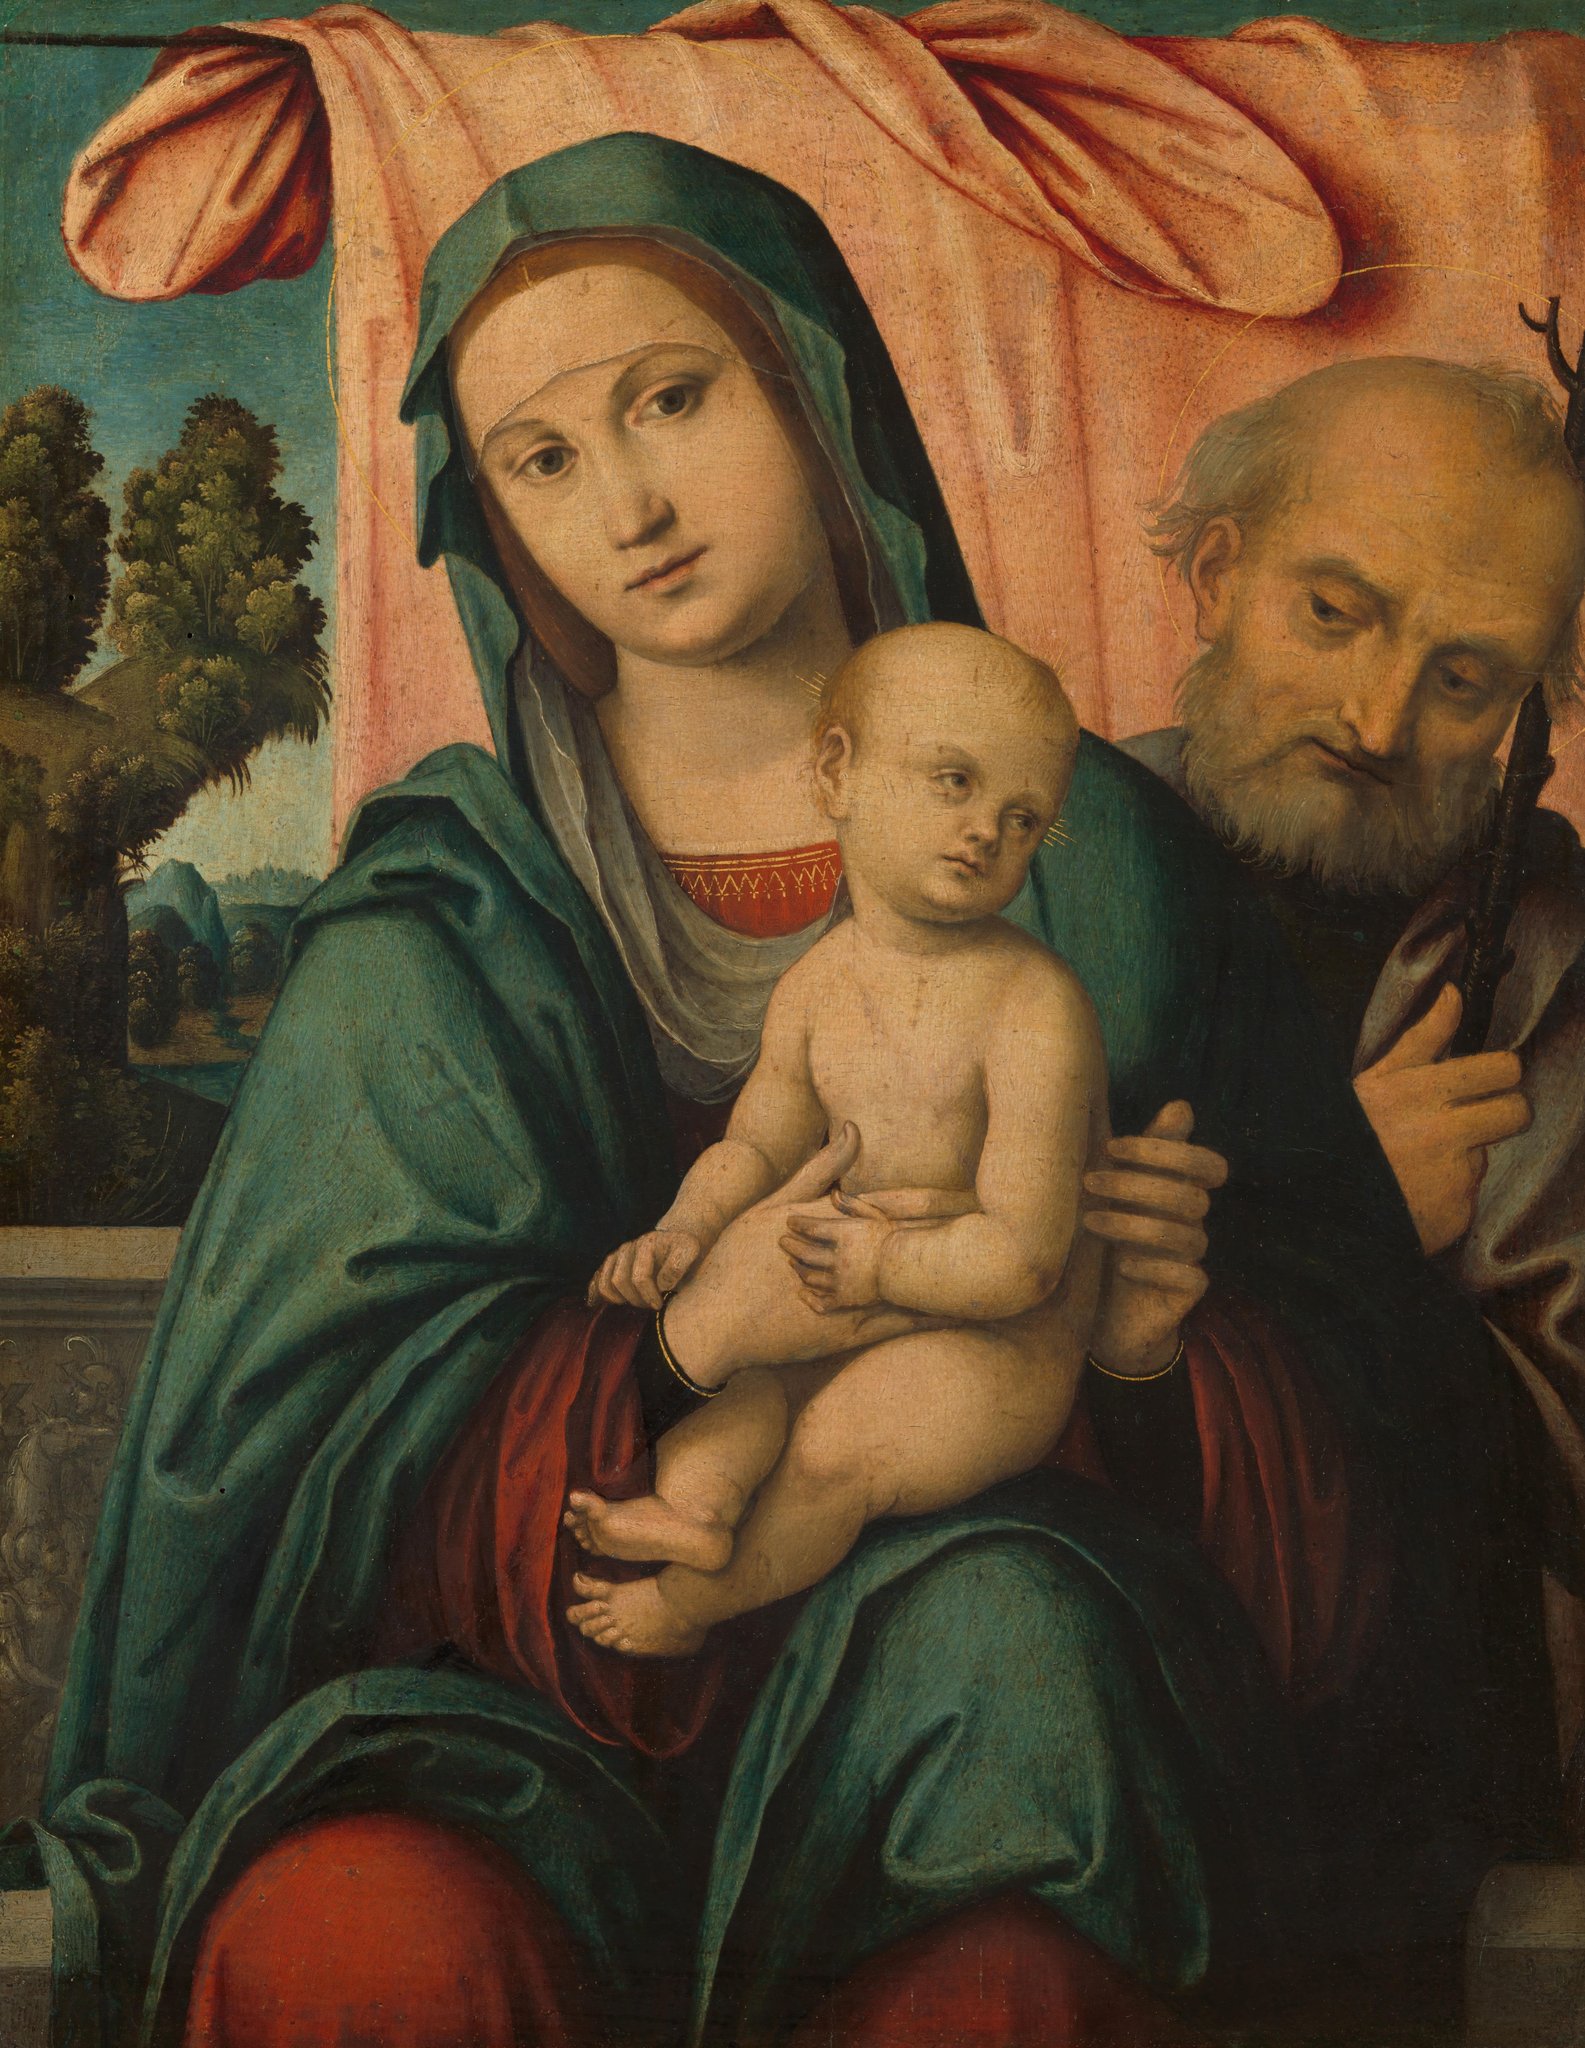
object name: painting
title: The Holy Family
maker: lorenzo costa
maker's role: painter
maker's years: 1460-1535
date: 1490-1510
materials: oil, panel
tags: mary sitting or enthroned, the christ-child sitting on her knee (christ-child to mary's left), holy family (alone), 'trinitas terrestris'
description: Attributed to Lorenzo Costa (1460 - 1535). Holy family. From the Augusteum, Oldenburg. Presented by a group of members of the Vereniging Rembrandt, 1925.